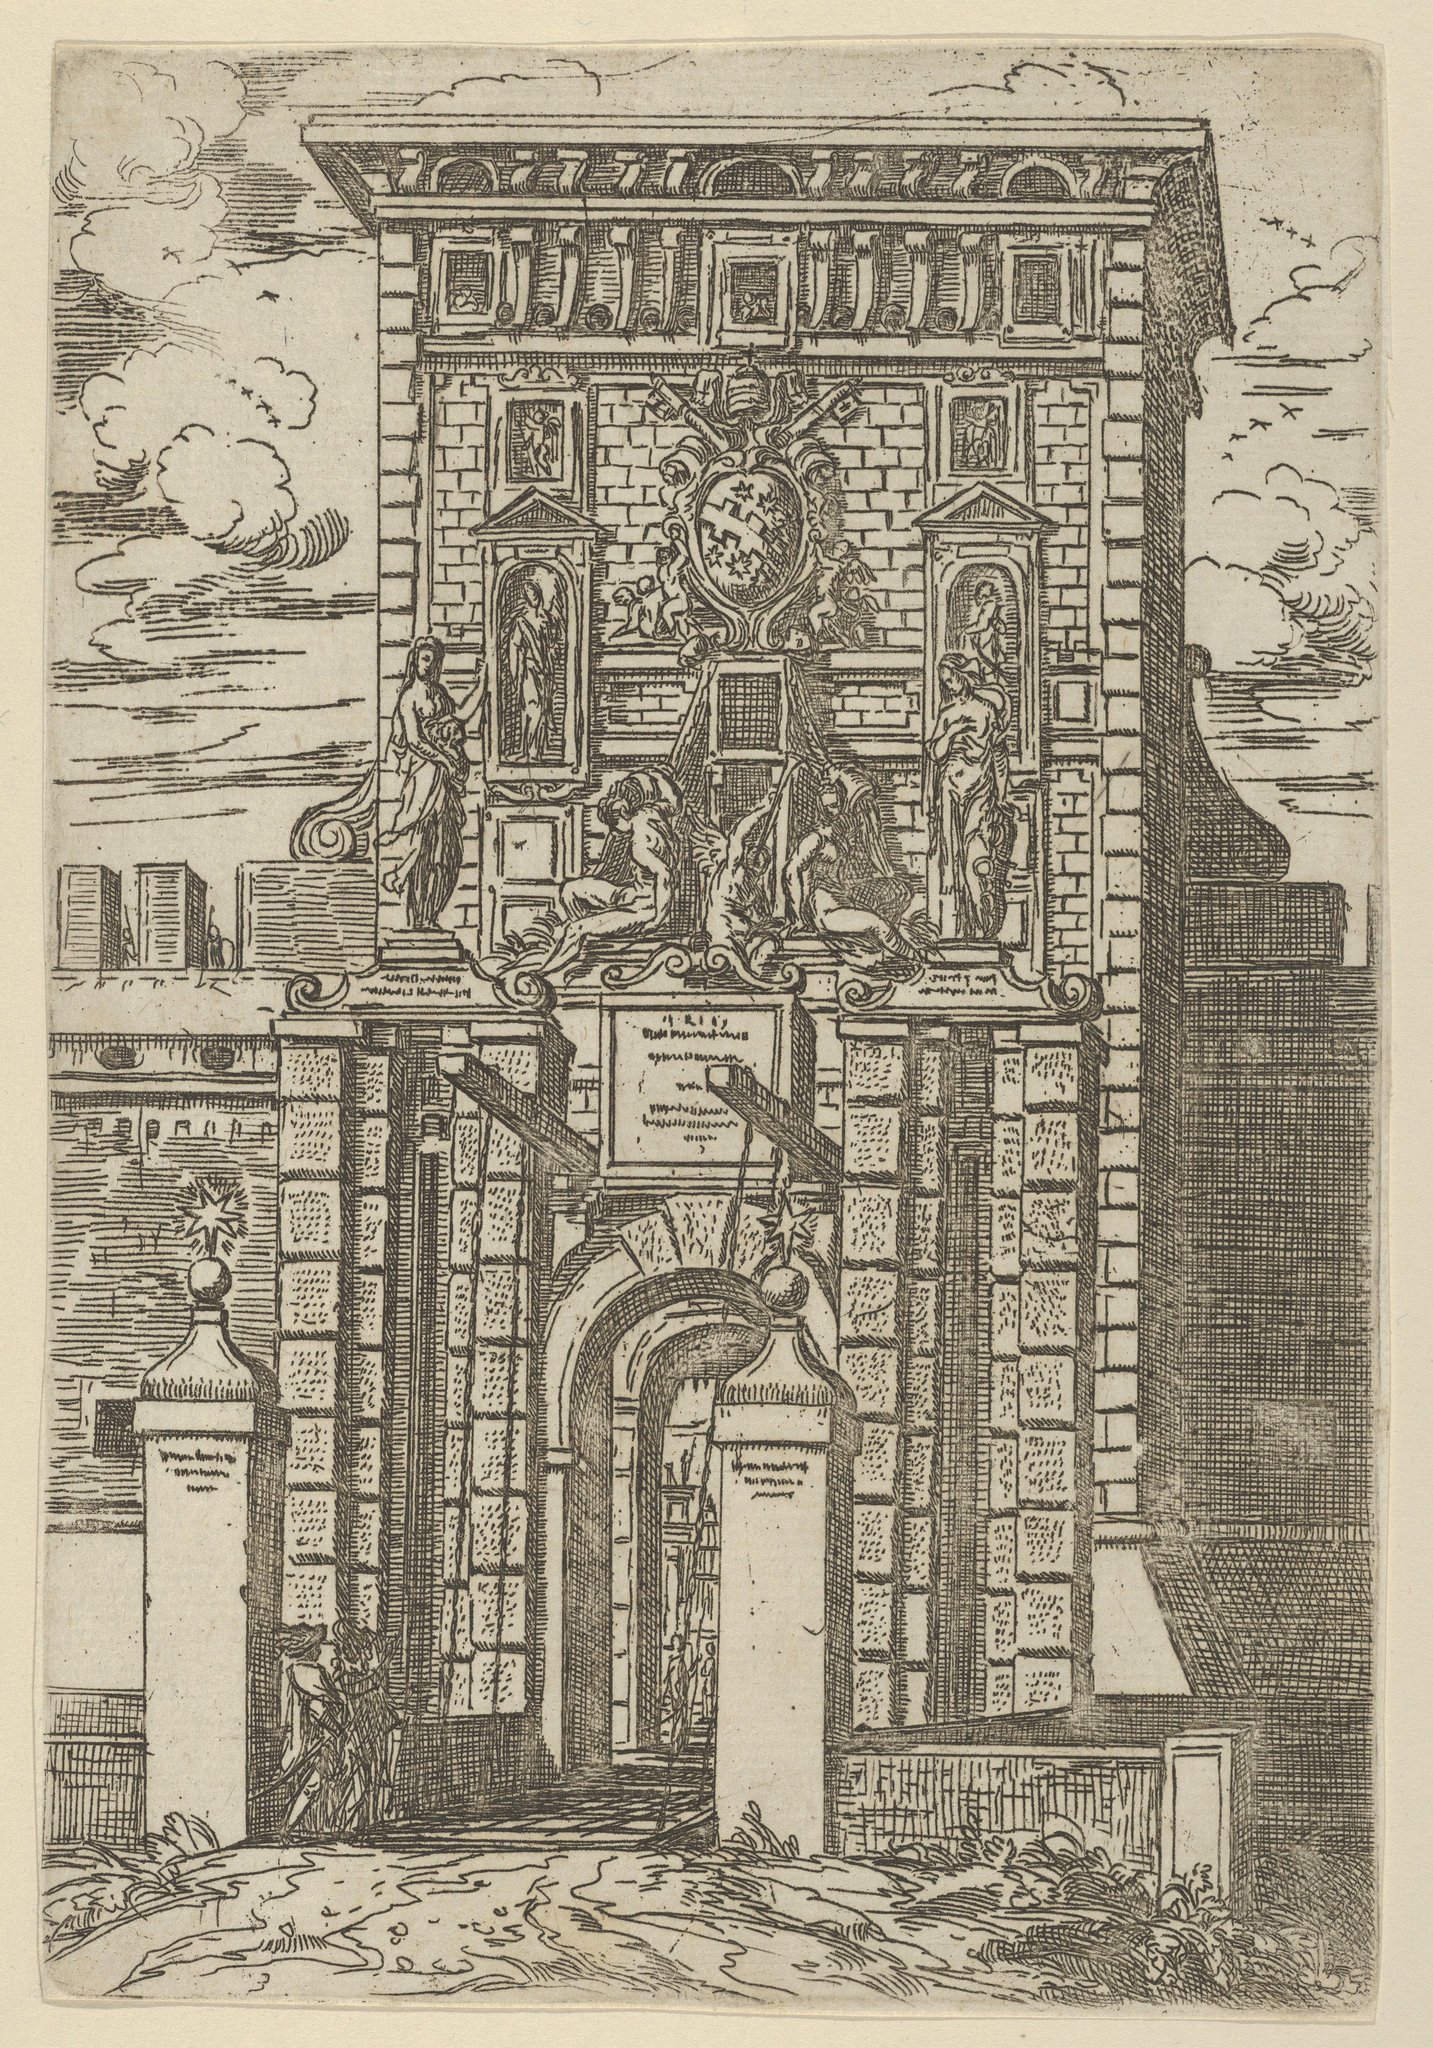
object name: print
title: The Porta Galliera, the entrance gate to Bologna and drawbridge with temporary decorations for the entry of Pope Clement VIII in Bologna in 1598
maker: guido reni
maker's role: artist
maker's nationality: italian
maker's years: 1575-1642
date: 1598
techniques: etching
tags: architecture,gates,coat of arms